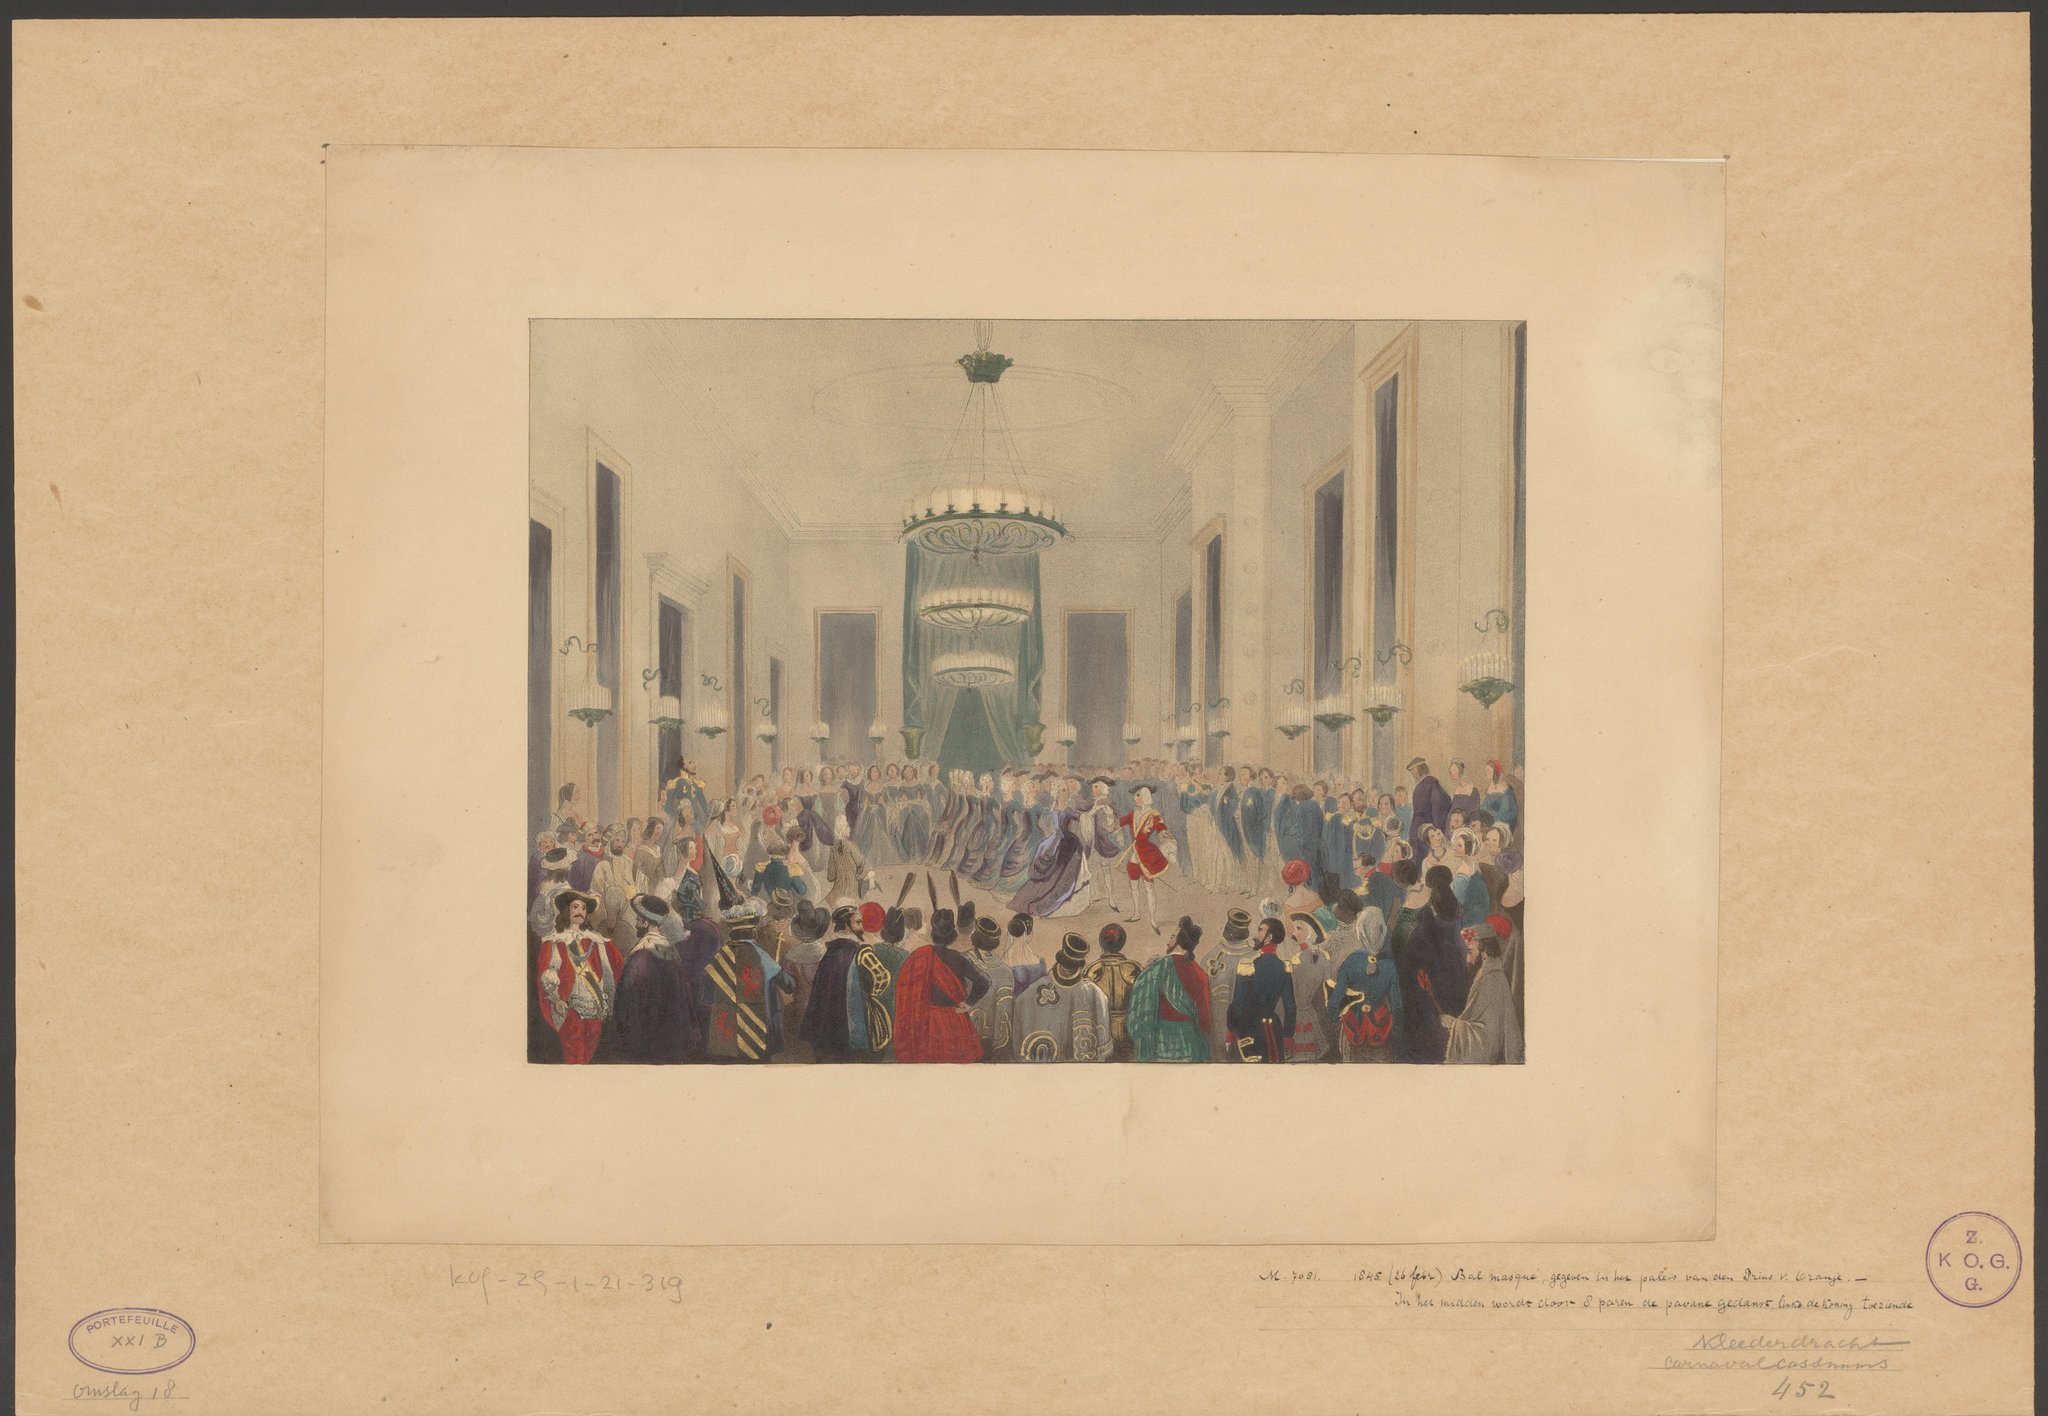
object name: print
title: Gemaskerd bal in het paleis van de Prins van Oranje, 1845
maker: elias spanier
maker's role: print maker, printer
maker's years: 1821-1863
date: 1845-1847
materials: paper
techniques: hand coloring, lithograph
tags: the hague, william ii of the netherlands, ball, formal dance, masquerade, masked ball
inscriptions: collector's mark: Lugt 1641, stamp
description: Acht paren dansen de pavane terwijl Willem II, koning der Nederlanden toekijkt. Onderwerpsrubrieken binnen de Atlas Zeden en Gewoonten: Zeden en Gewoonten in Engeren Zin, De Kleeding, Kleederdrachten (tijdvakken), Carnavalcostuums. (niet veel, prenten bal Willem II).